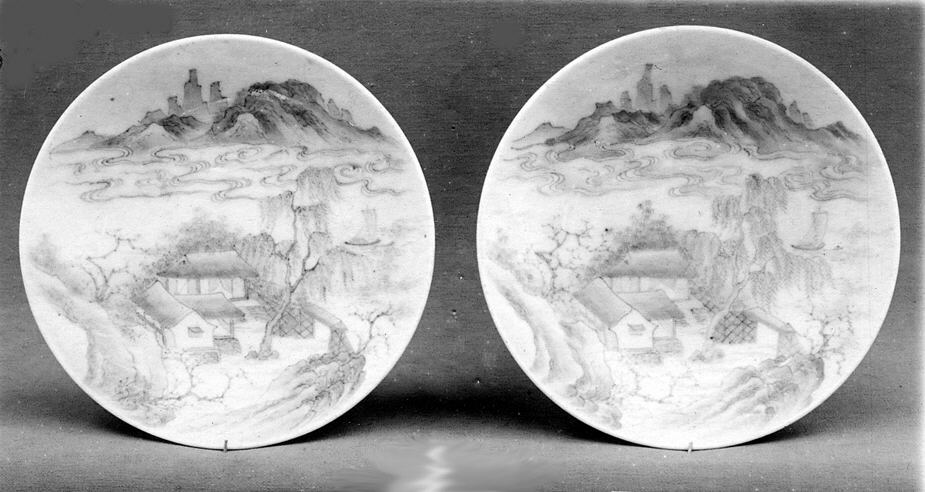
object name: saucer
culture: japanese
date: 1800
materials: porcelain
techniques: underglaze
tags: landscapes